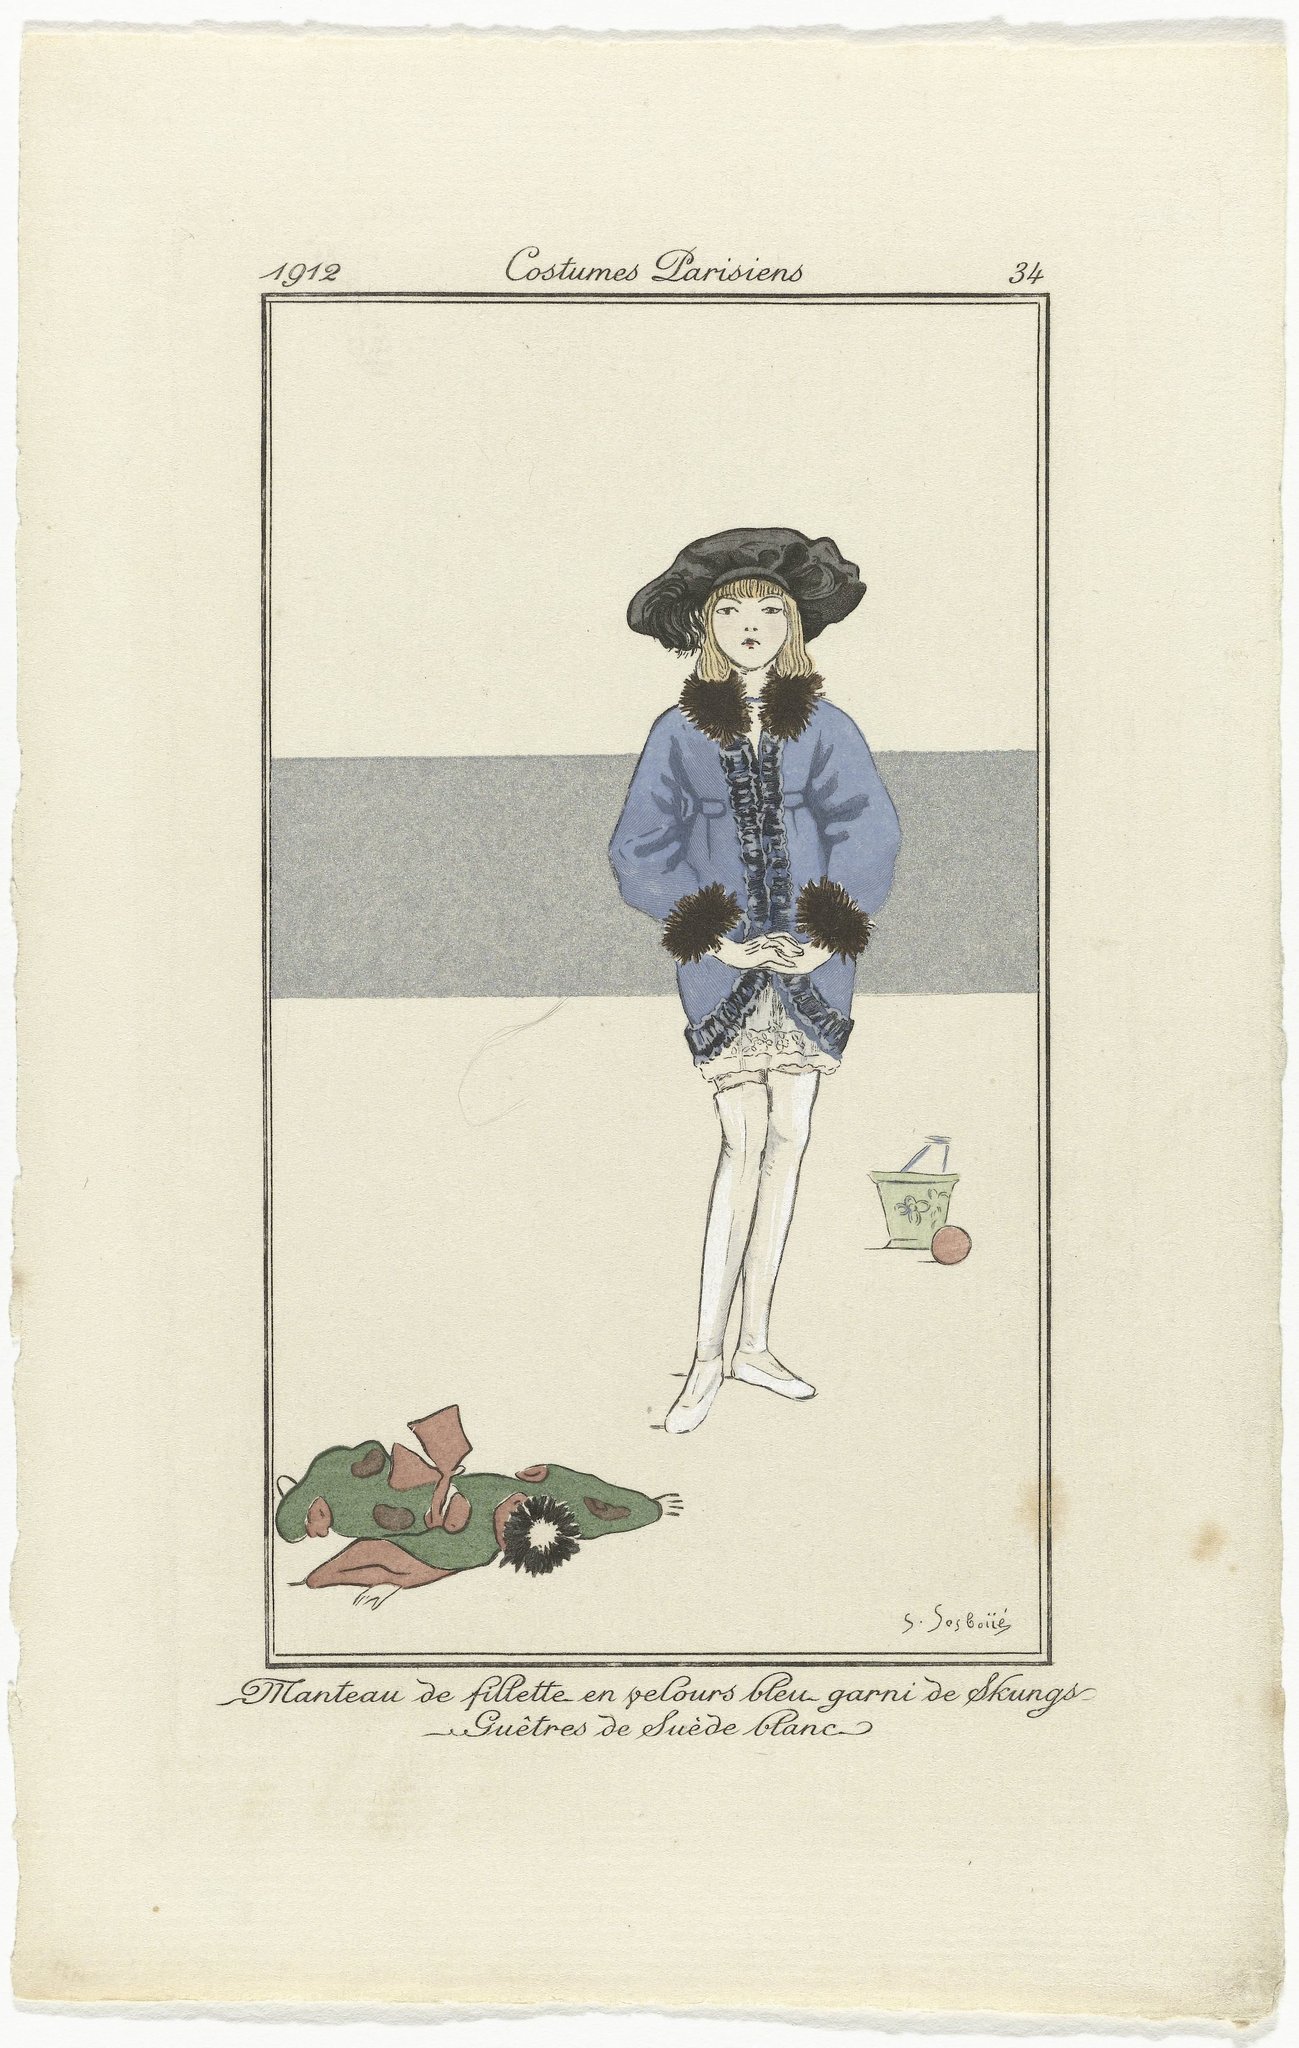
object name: fashion print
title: Journal des Dames et des Modes, Costumes Parisiens, 1912, No. 34 : Manteau de fillett (...)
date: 1912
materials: paper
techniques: engraving, hand coloring, pochoir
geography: paris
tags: ornamental parts of clothing (+ fur used for clothes), head-gear (+ girls' clothes), coat (+ girls' clothes), fashion plates, (playing with) dolls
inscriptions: caption: ‘Manteau de fillette en velours bleu garni de Skungs Guêtres de Suède blanc’, title: ‘Costumes Parisiens’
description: Meisje in een mantel van blauw fluweel versierd met skunk. Slobkousen van wit suède. Op de voorgrond ligt een pop; op de achtergrond een emmer en bal. Prent uit het modetijdschrift Journal des Dames et des Modes (1912-1914).